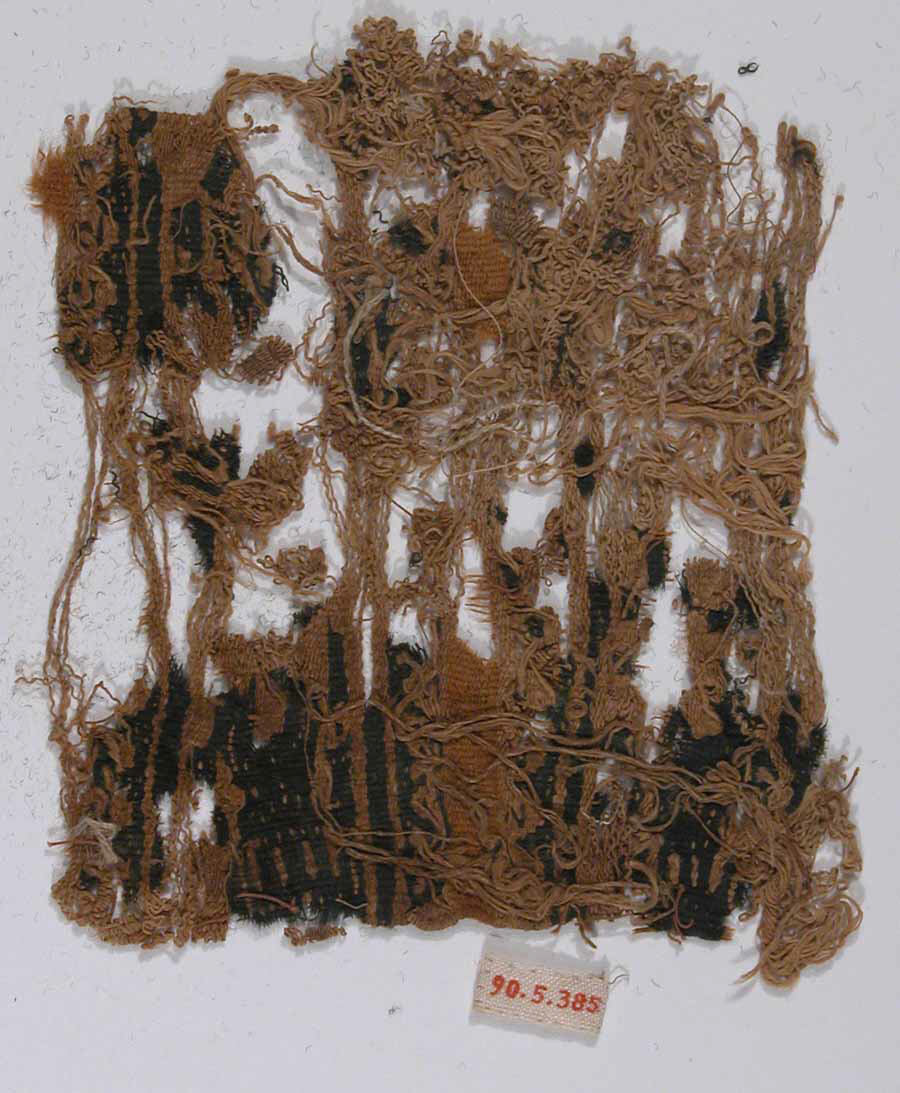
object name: textile fragment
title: Fragment of a Sleeve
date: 301-500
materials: linen, wool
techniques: weave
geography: egypt